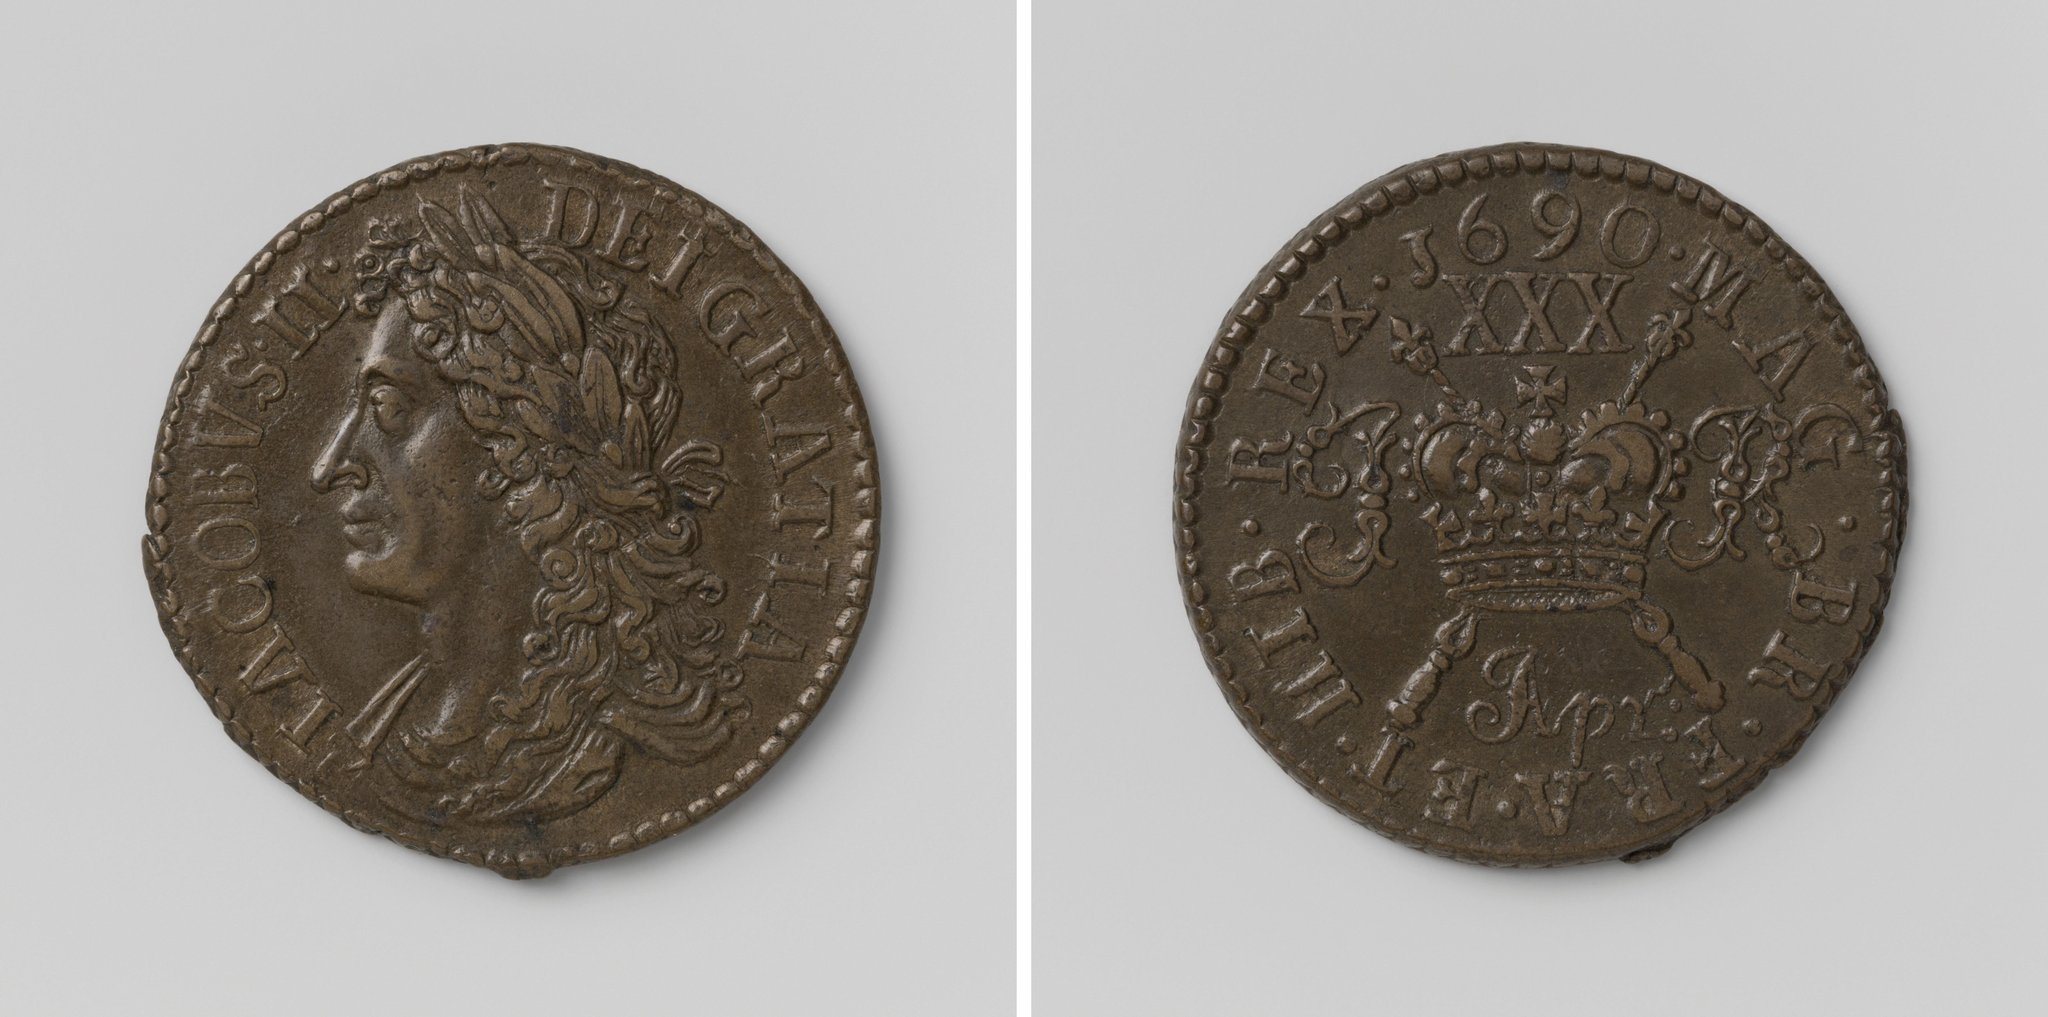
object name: siege coin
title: Halve crown, noodmunt van Jacobus II, koning van Engeland, uit april 1690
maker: Anonymous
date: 1604-1690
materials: copper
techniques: striking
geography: ireland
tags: jacobus ii (koning van engeland en schotland)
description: Voorzijde: borststuk man met lauwerkrans binnen omschrift. Keerzijde: kroon, waardoor twee gekruiste scepters steken tussen monogram van letters J en R; boven kroon Romeinse cijfer XXX, onder kroon opschrift "Apr: " binnen omschrift